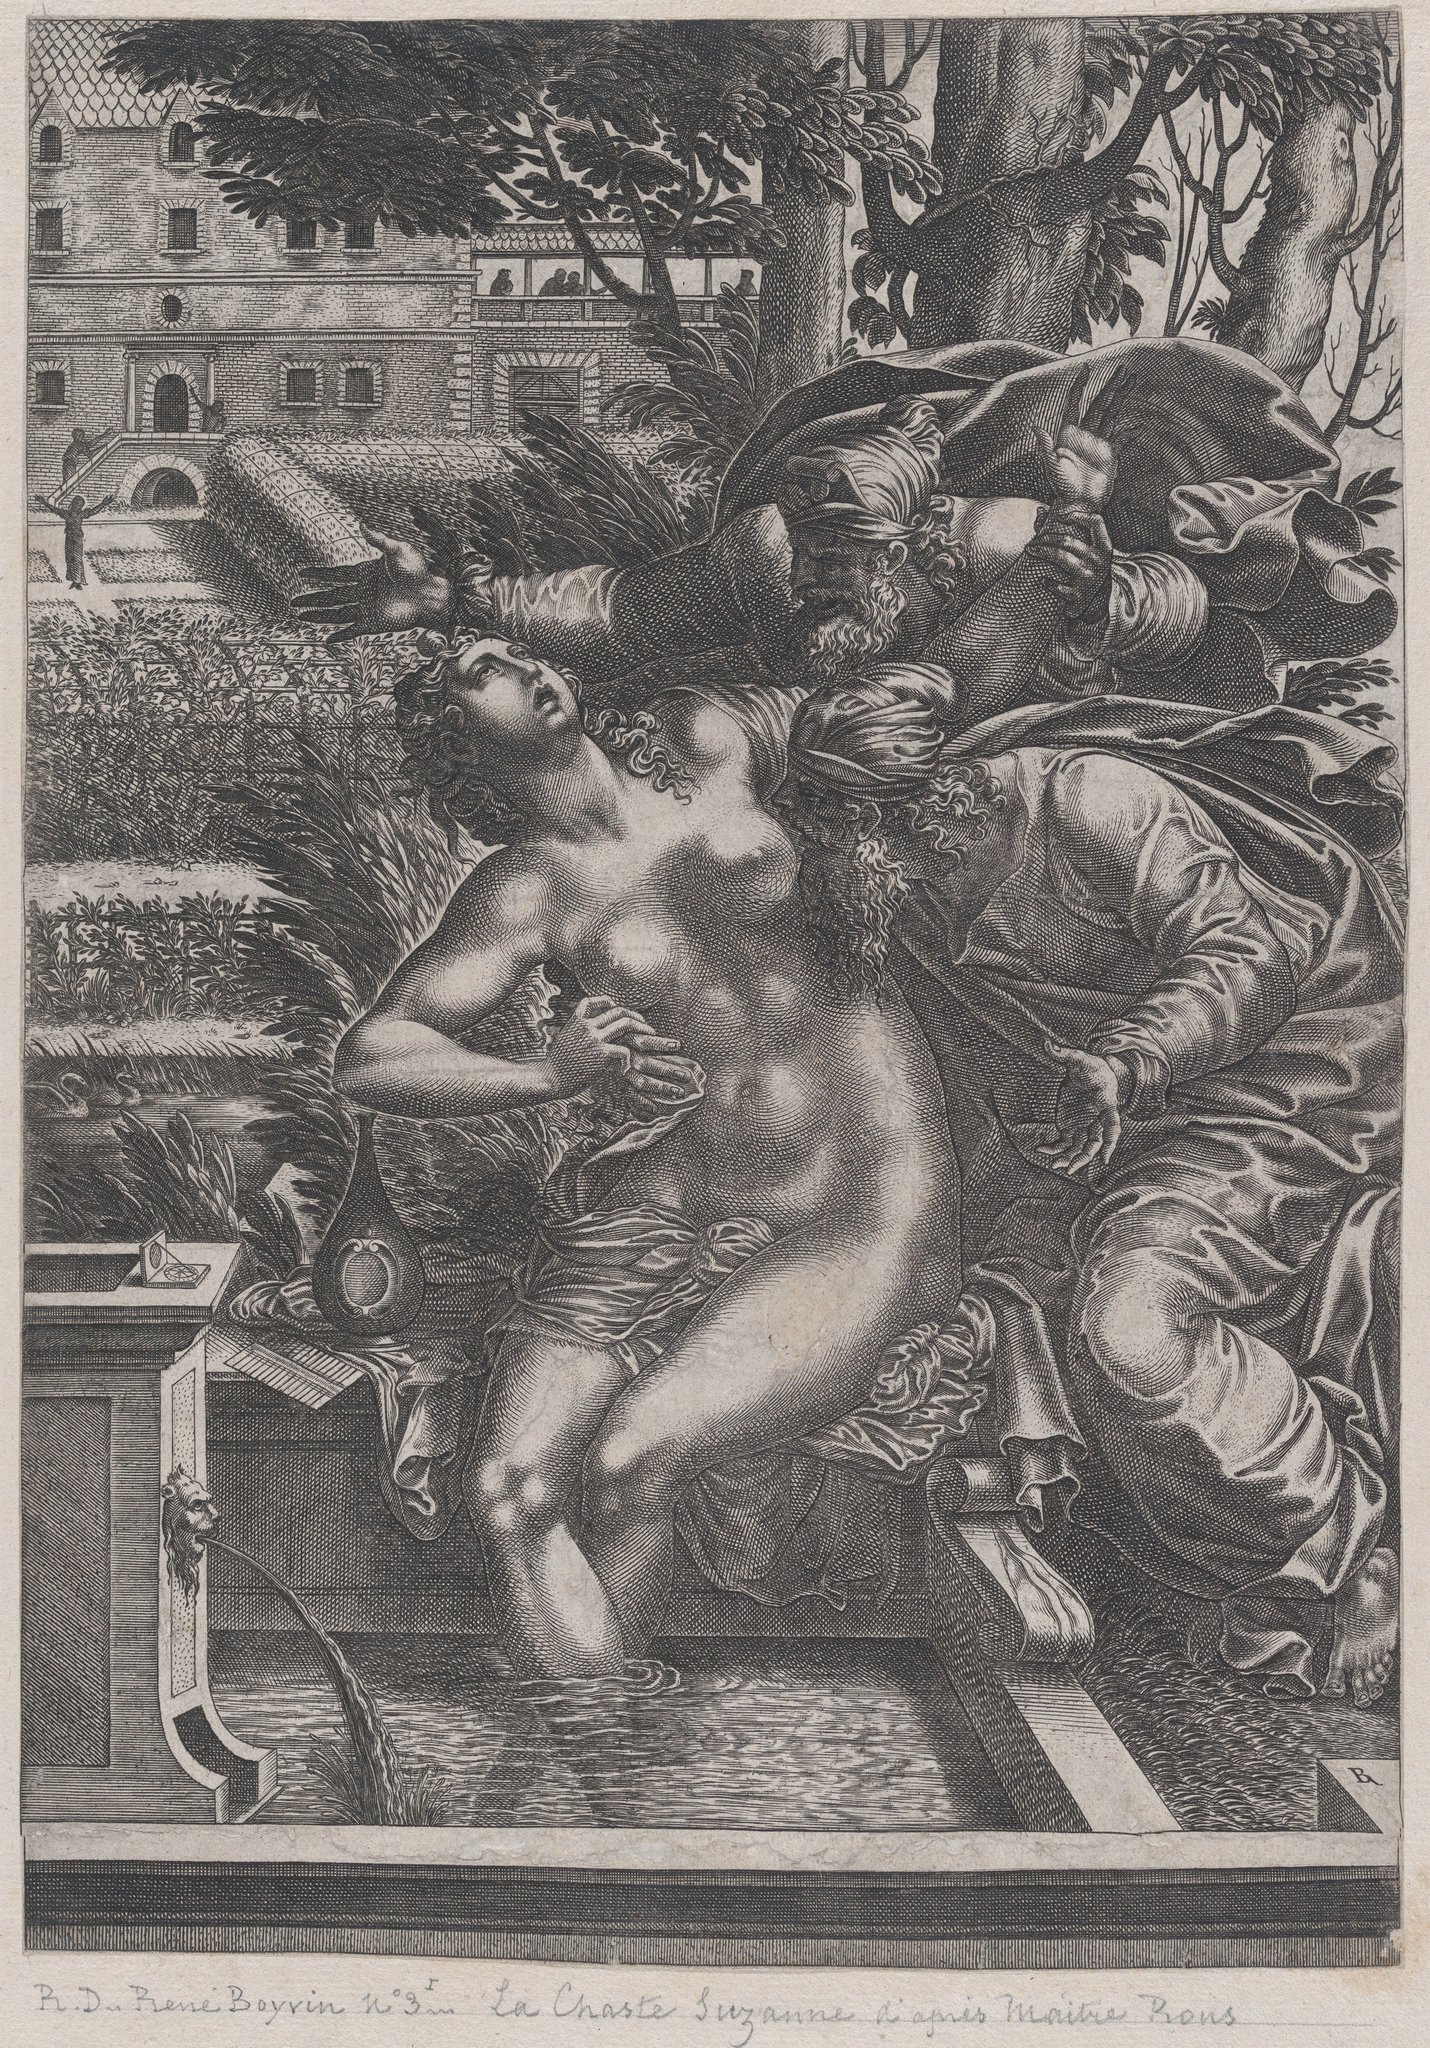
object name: print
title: Susanna and the Elders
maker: rené boyvin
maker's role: artist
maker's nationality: french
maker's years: 1525-1598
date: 1525-1598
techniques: engraving